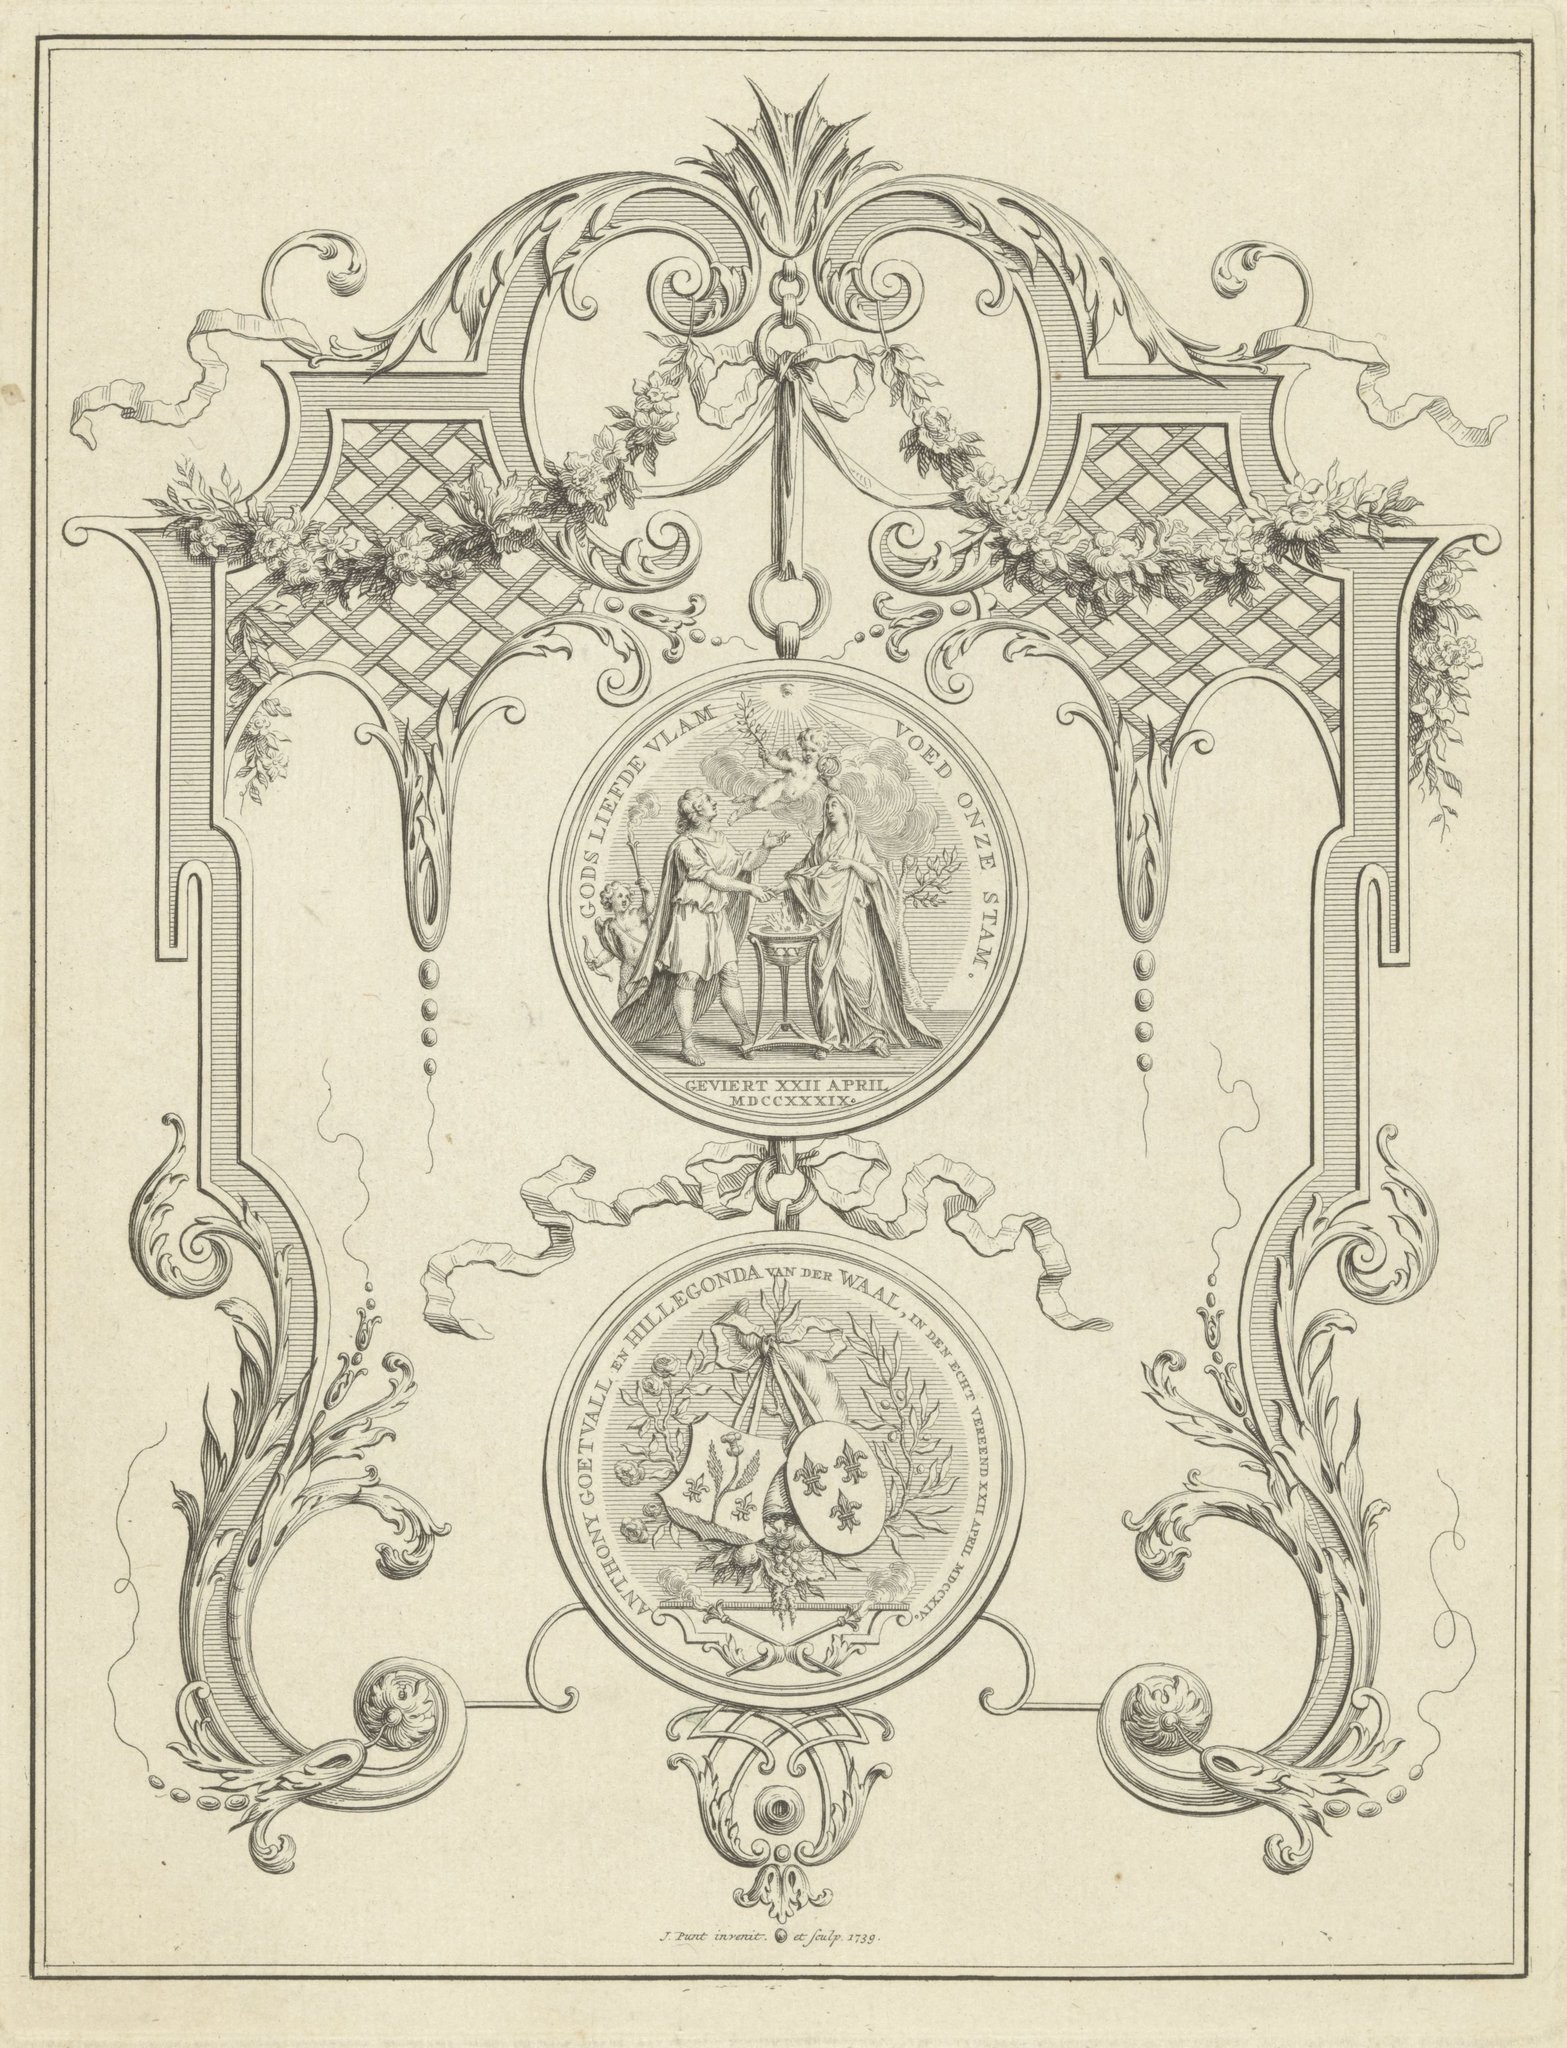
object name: print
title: Decoratieve voorstelling met penning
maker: jan punt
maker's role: draughtsman, print maker, publisher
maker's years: 1711-1779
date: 1739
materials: paper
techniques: etching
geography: netherlands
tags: silver anniversary, medal (considered as a piece of sculpture, regardless of its specific function)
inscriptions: collector's mark: Lugt 2228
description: Decoratieve voorstelling met de penning ter gelegenheid van het zilveren huwelijksjubileum van Anthony Goetvall en Hillegonda van der Waal (getrouwd 22 april 1714).